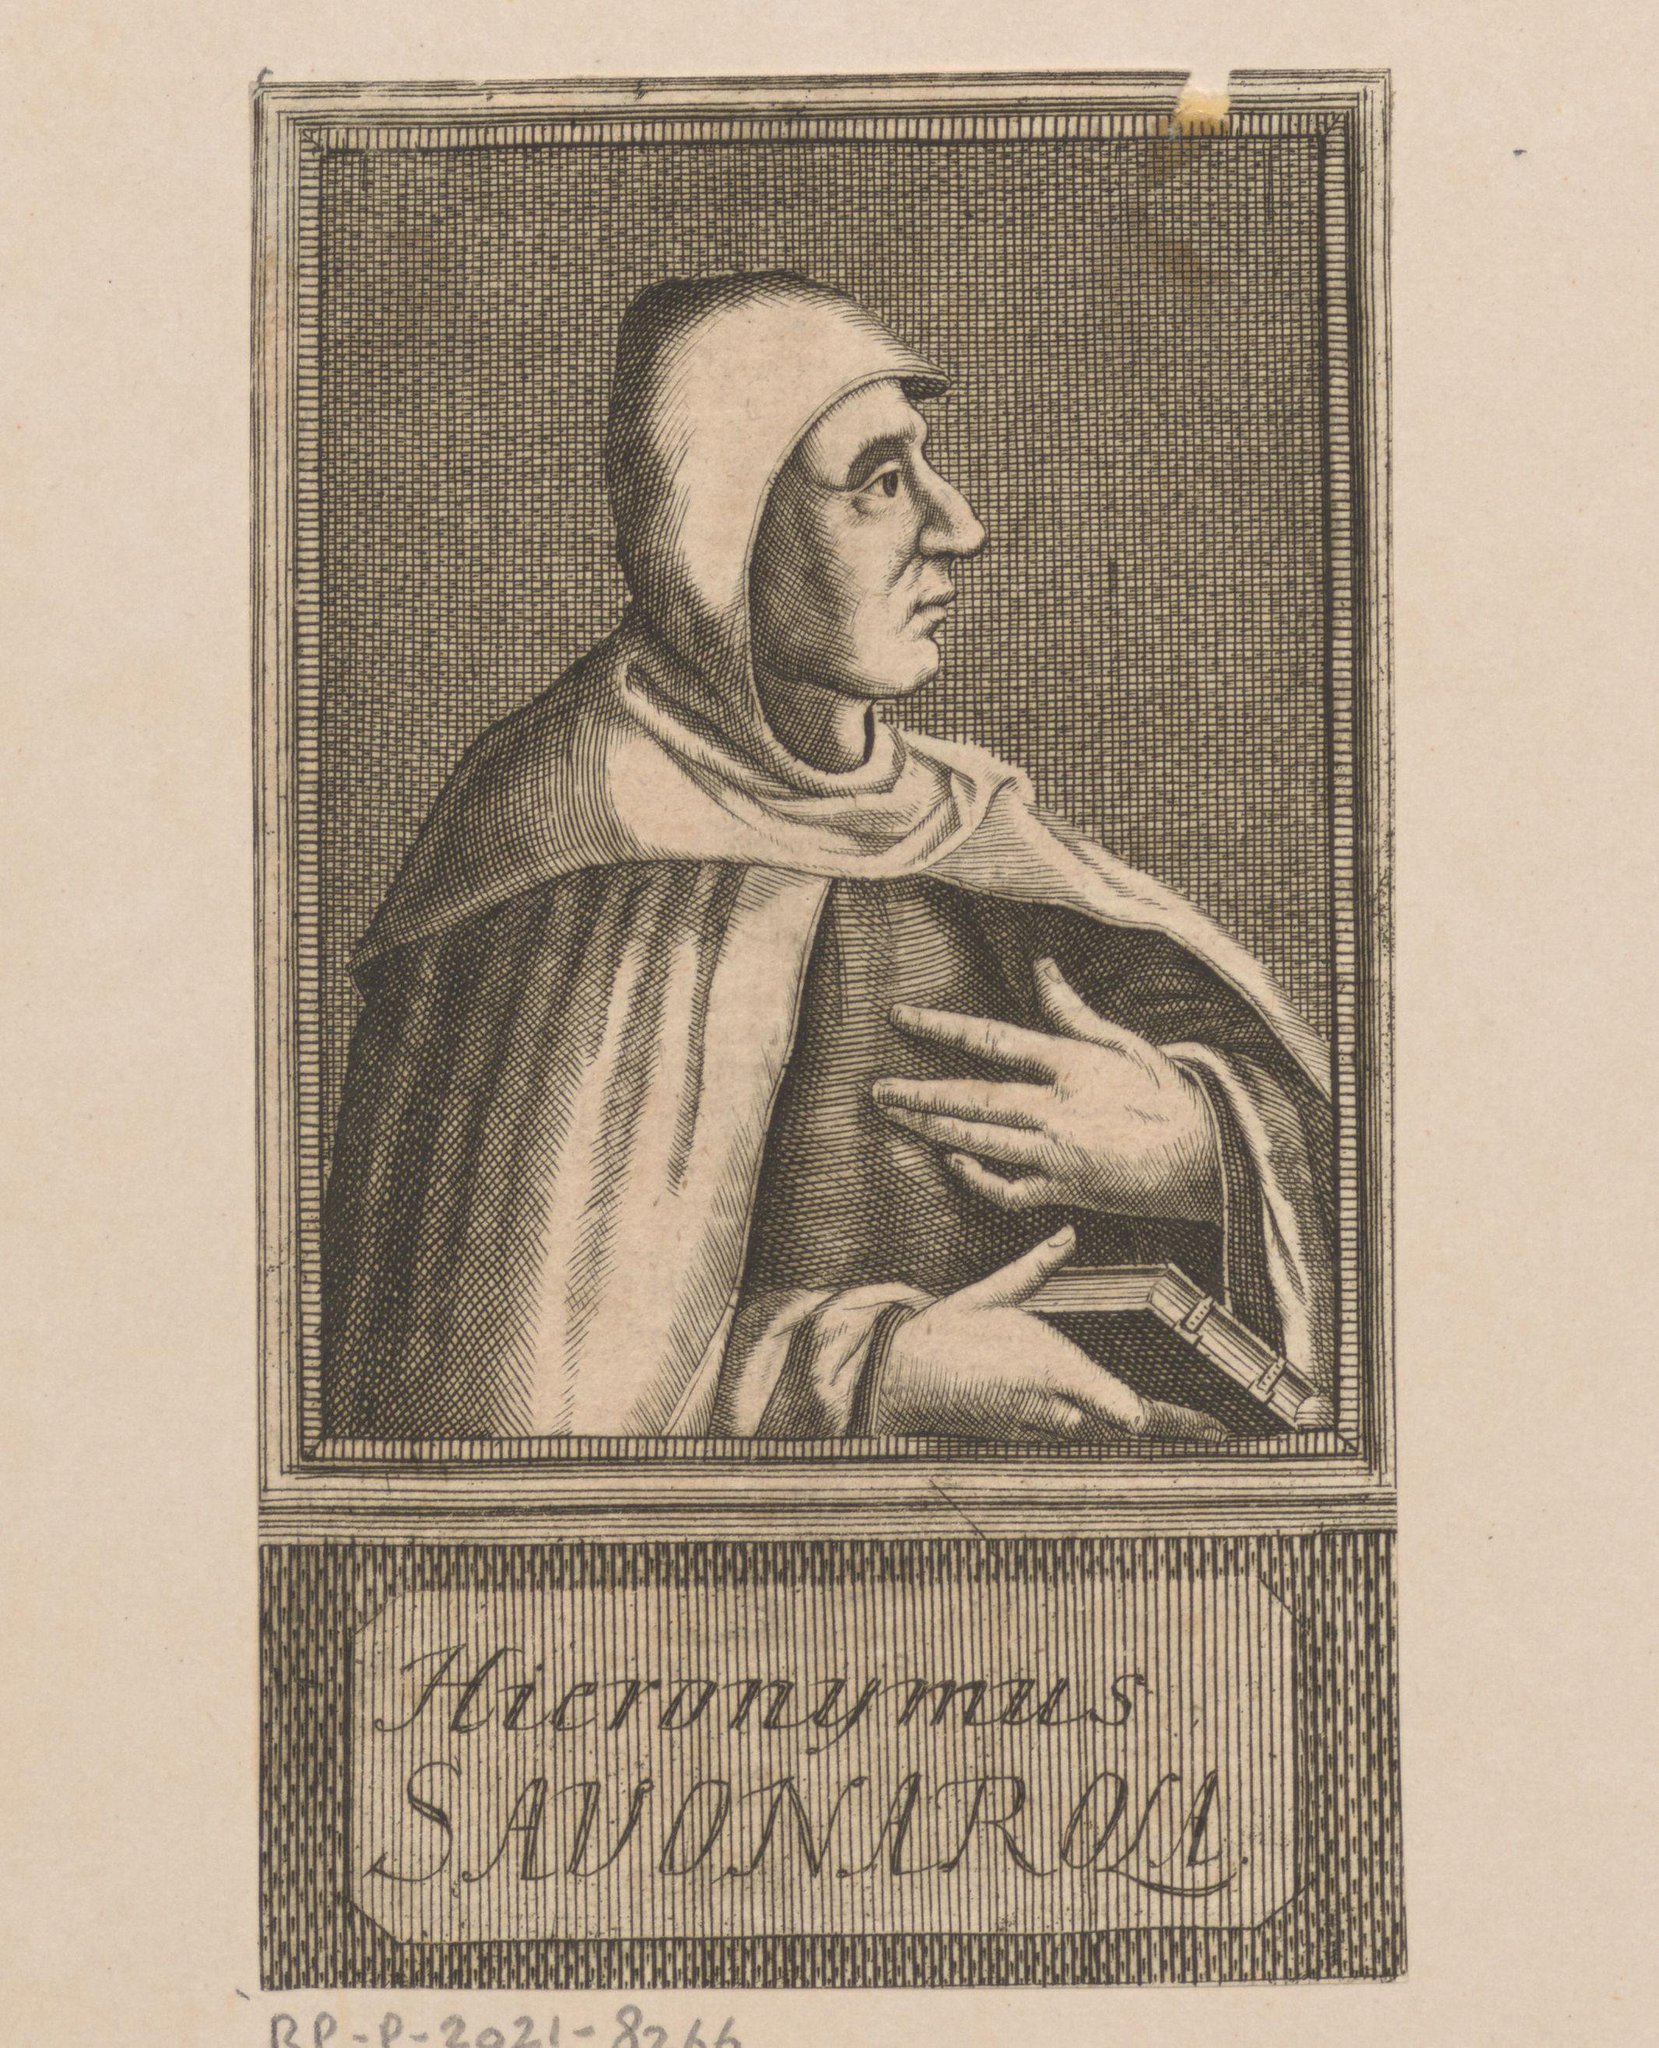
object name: print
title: Portret van Girolamo Savonarola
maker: Anonymous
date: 1713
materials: paper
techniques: engraving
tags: priest, politician, historical persons, monastic orders, monastic life: dominicans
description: Prent mogelijk uit: Neue Bibliothec oder Nachricht und Urtheile von neuen Büchern und allerhand zur Gelehrsamkeit dienenden Sachen. Frankfurt am Main en Leipzig: Rengerische Buchhandlung, 1713.